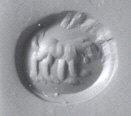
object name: stamp seal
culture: sasanian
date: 401-700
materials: stone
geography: iran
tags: animals